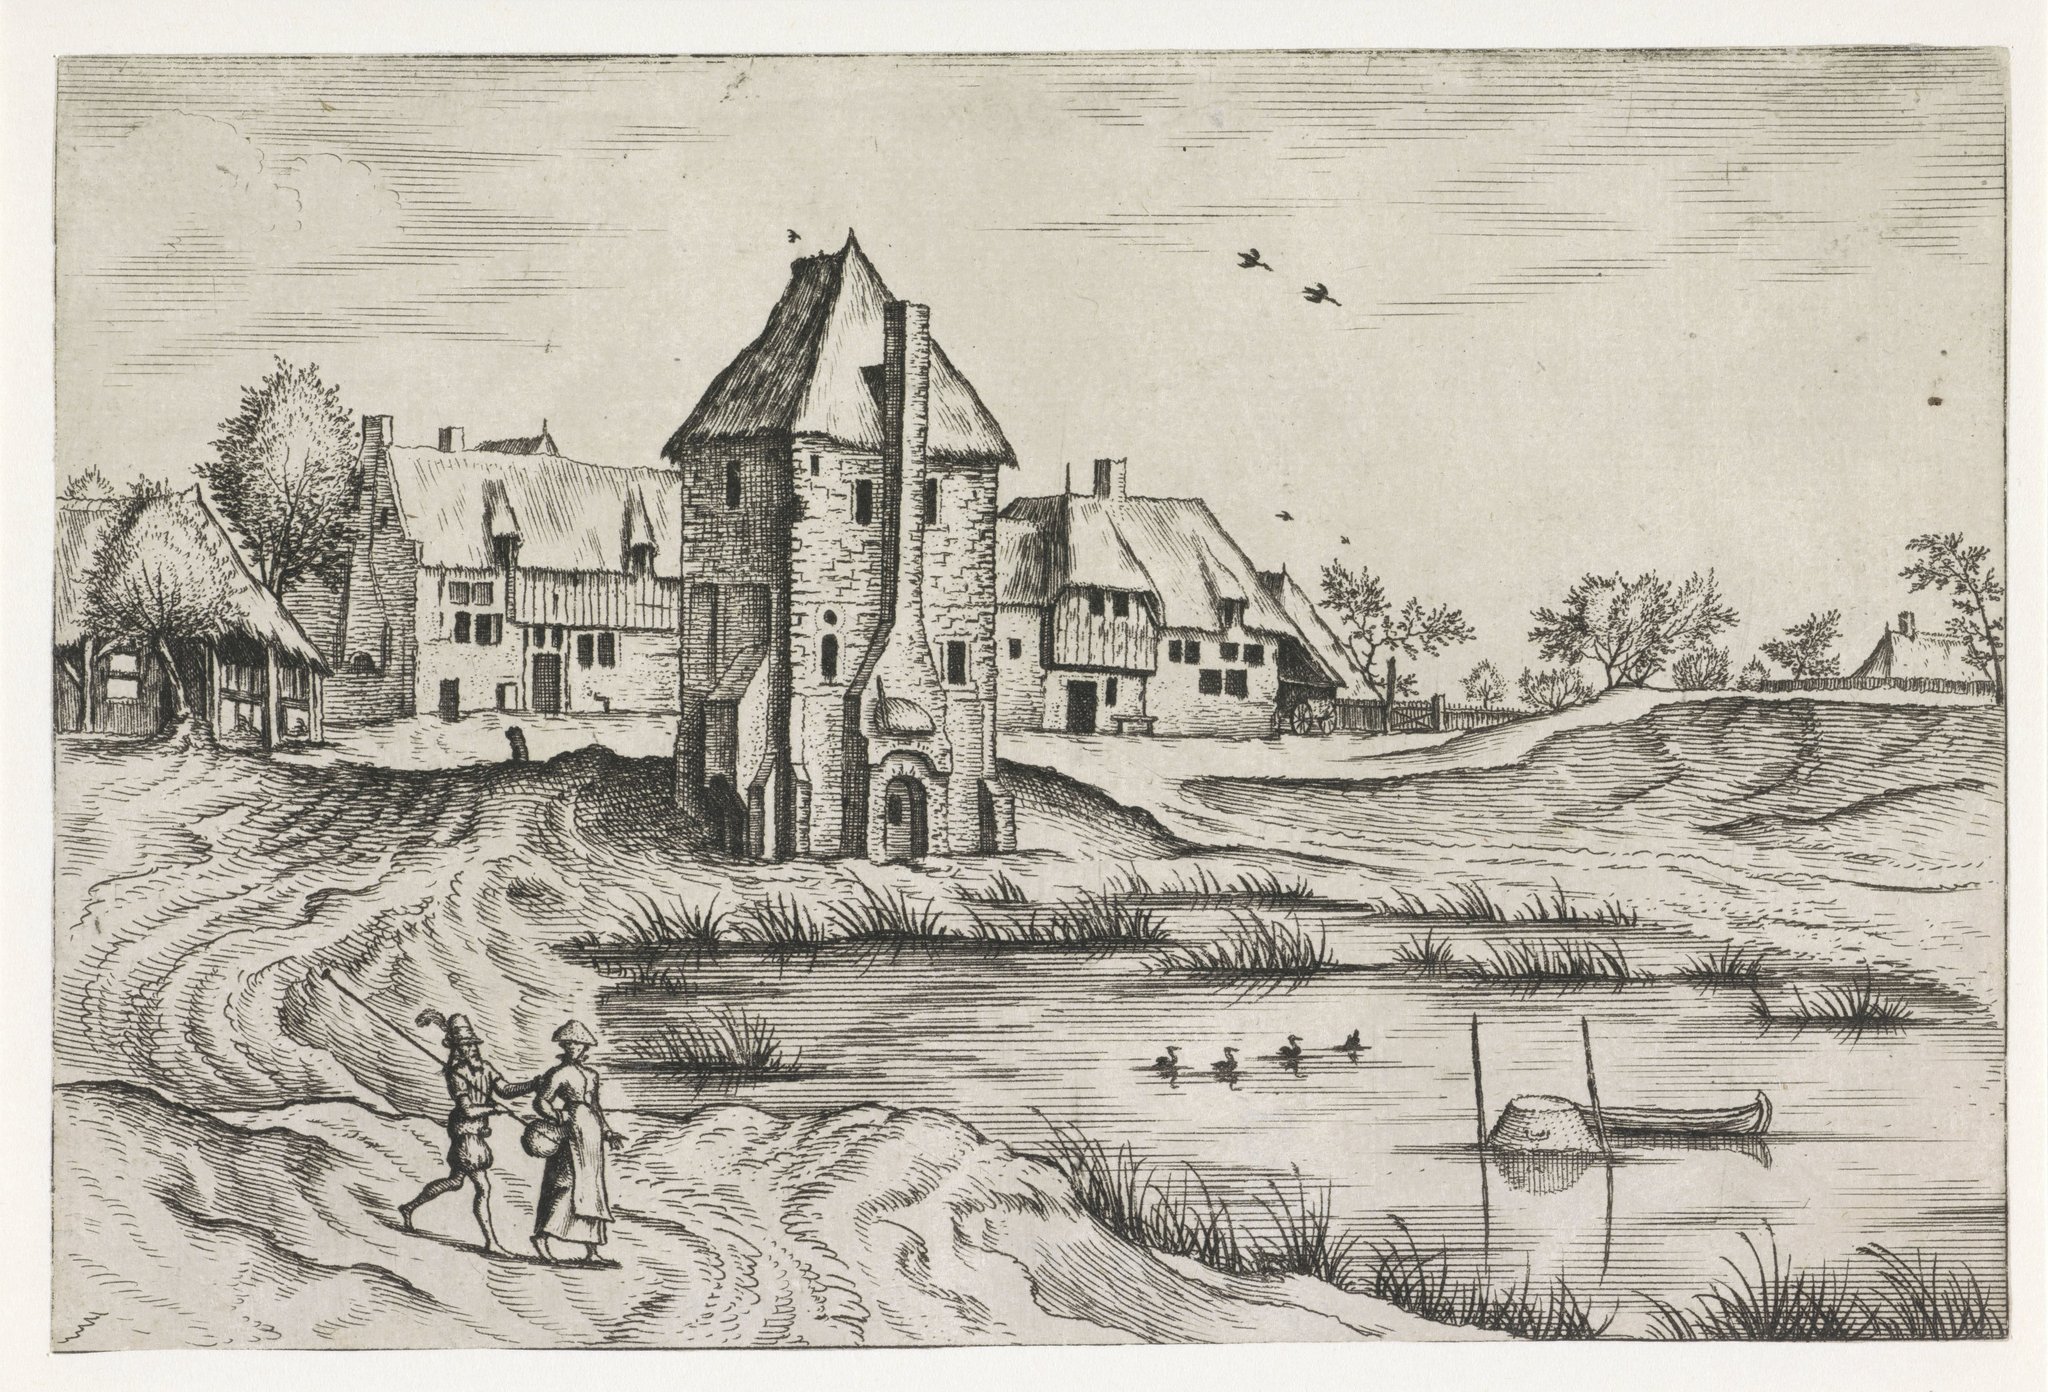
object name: print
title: Kleine landschappen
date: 1559-1561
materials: paper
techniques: etching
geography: antwerp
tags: rural housing, e.g. country-house, villa, cottage, pond, pool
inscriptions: collector's mark: Lugt 2760, collector's mark: Lugt 2228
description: Landschap met huizen aan een poel. Links op de voorgrond een man en een vrouw.